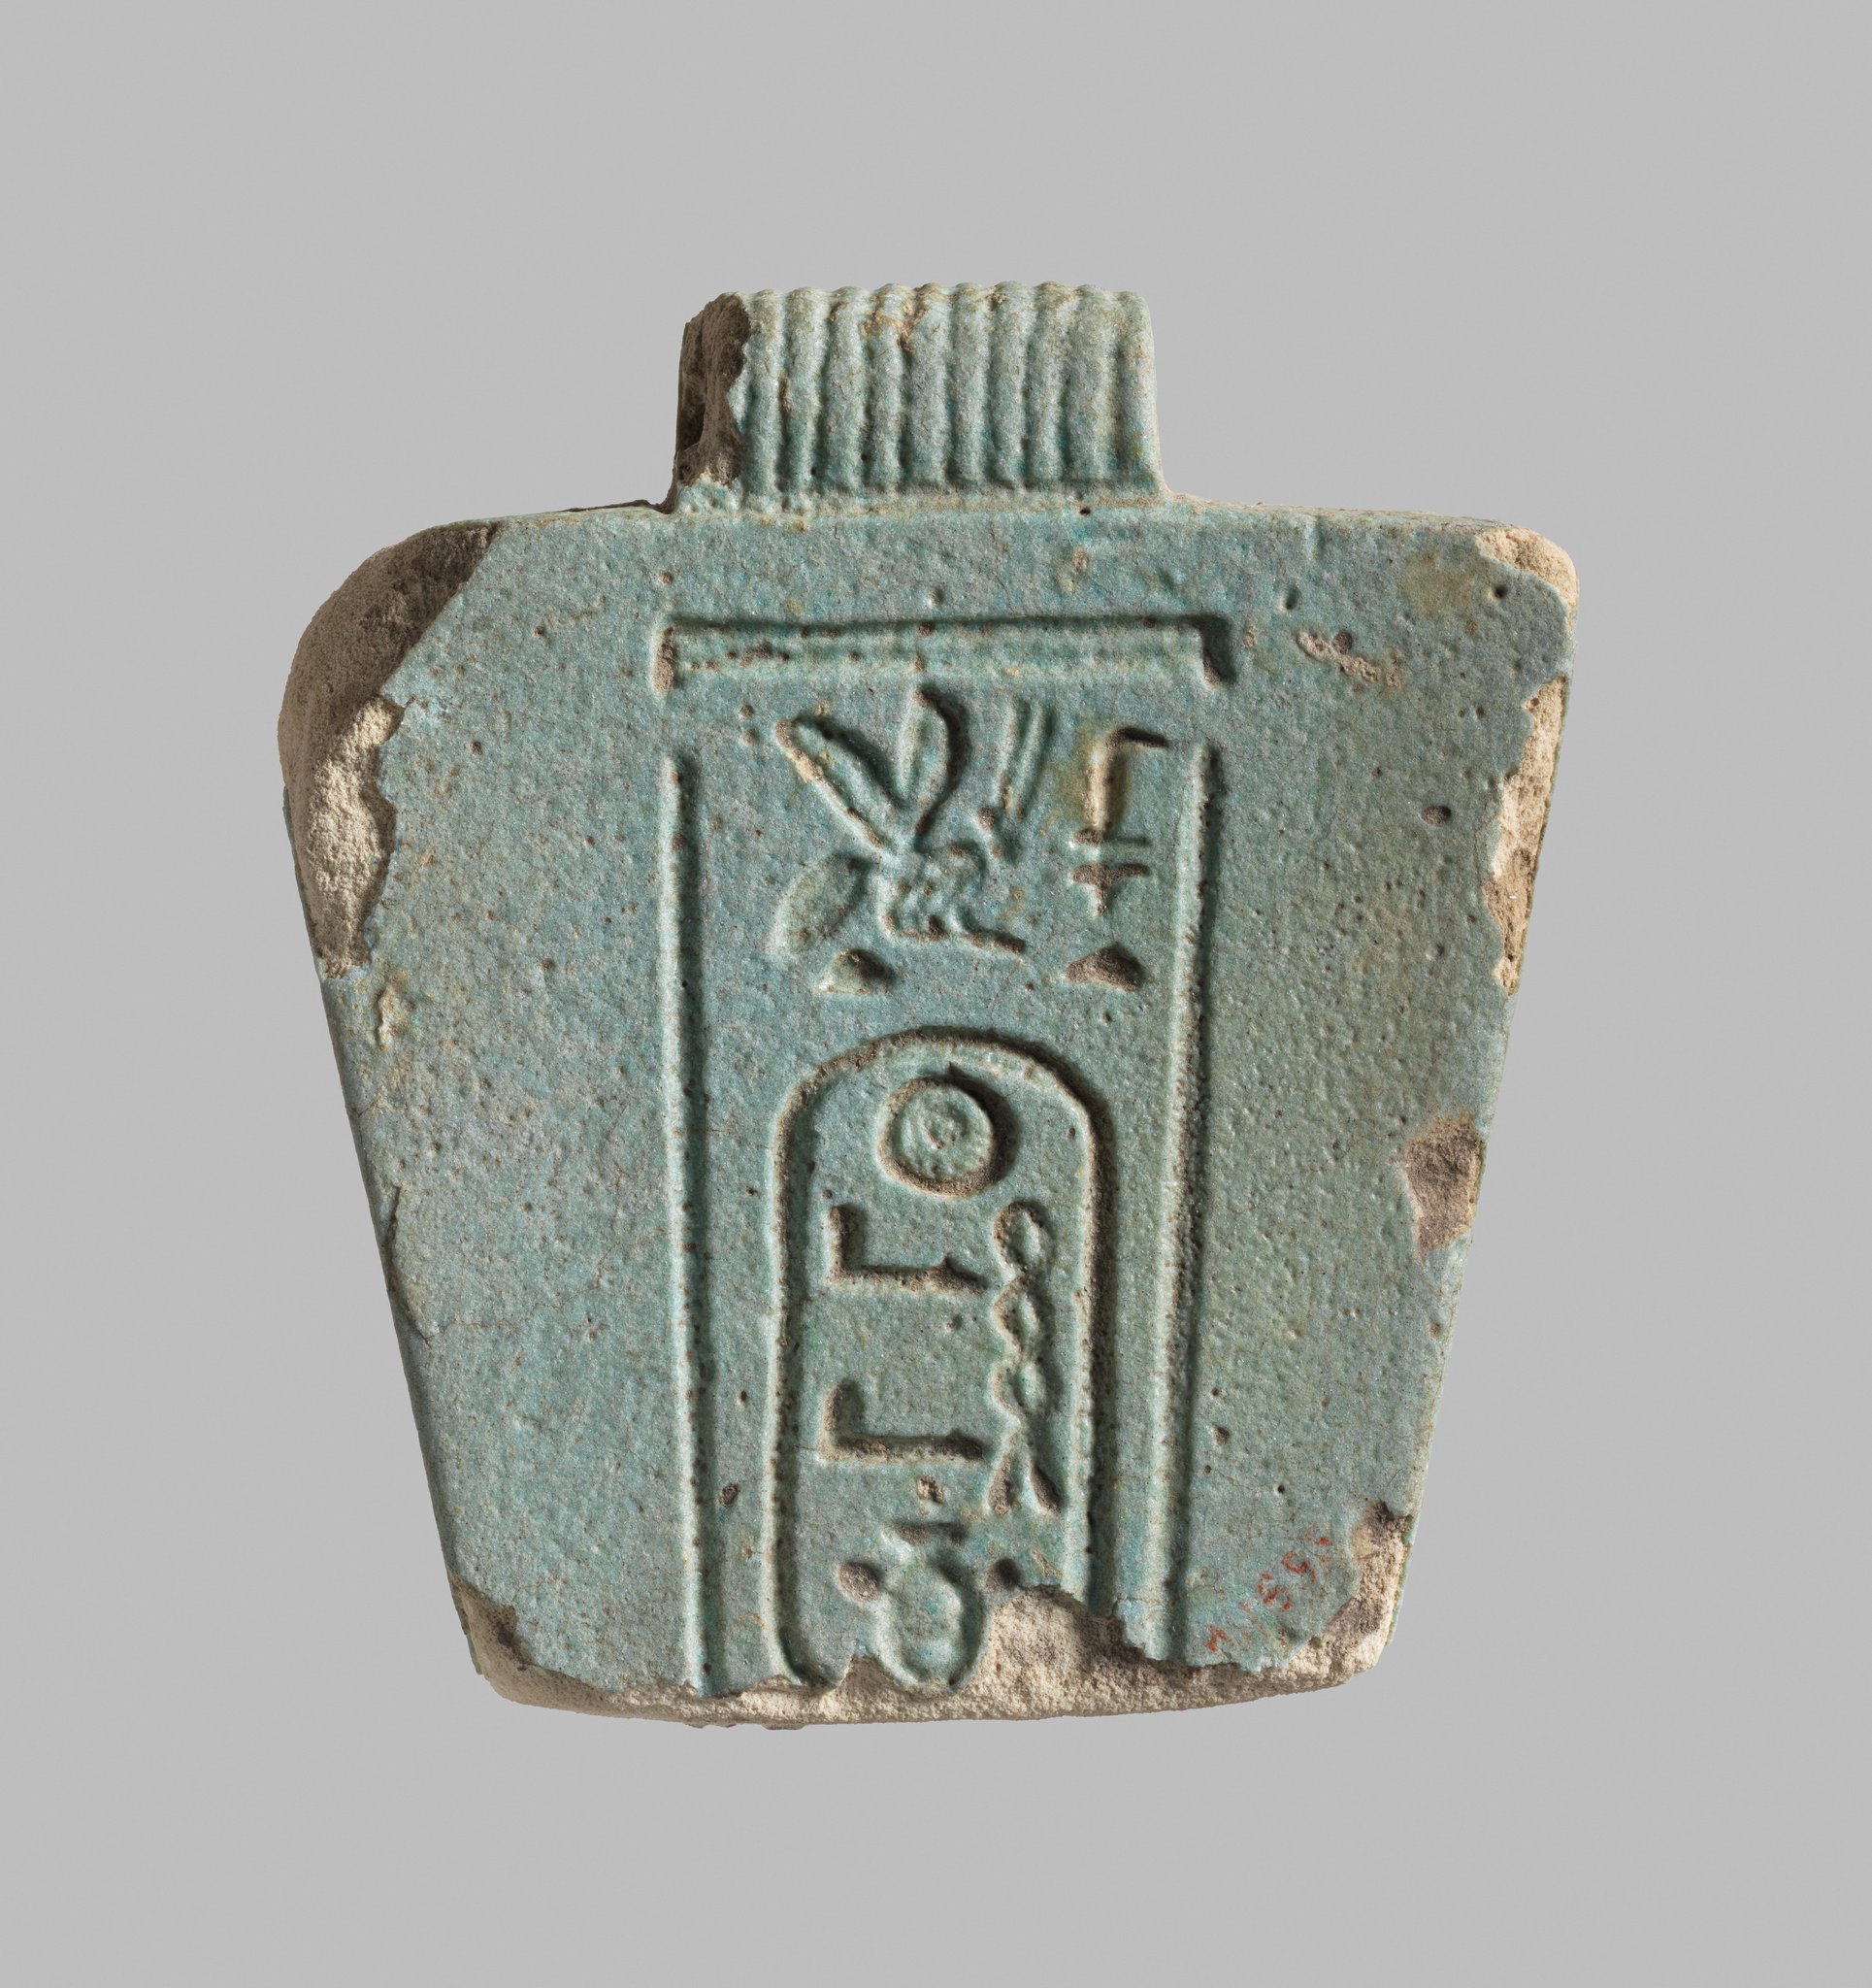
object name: menat fragment, amasis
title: Menat fragment, Apries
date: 589-570 BCE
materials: limestone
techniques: glazing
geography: egypt